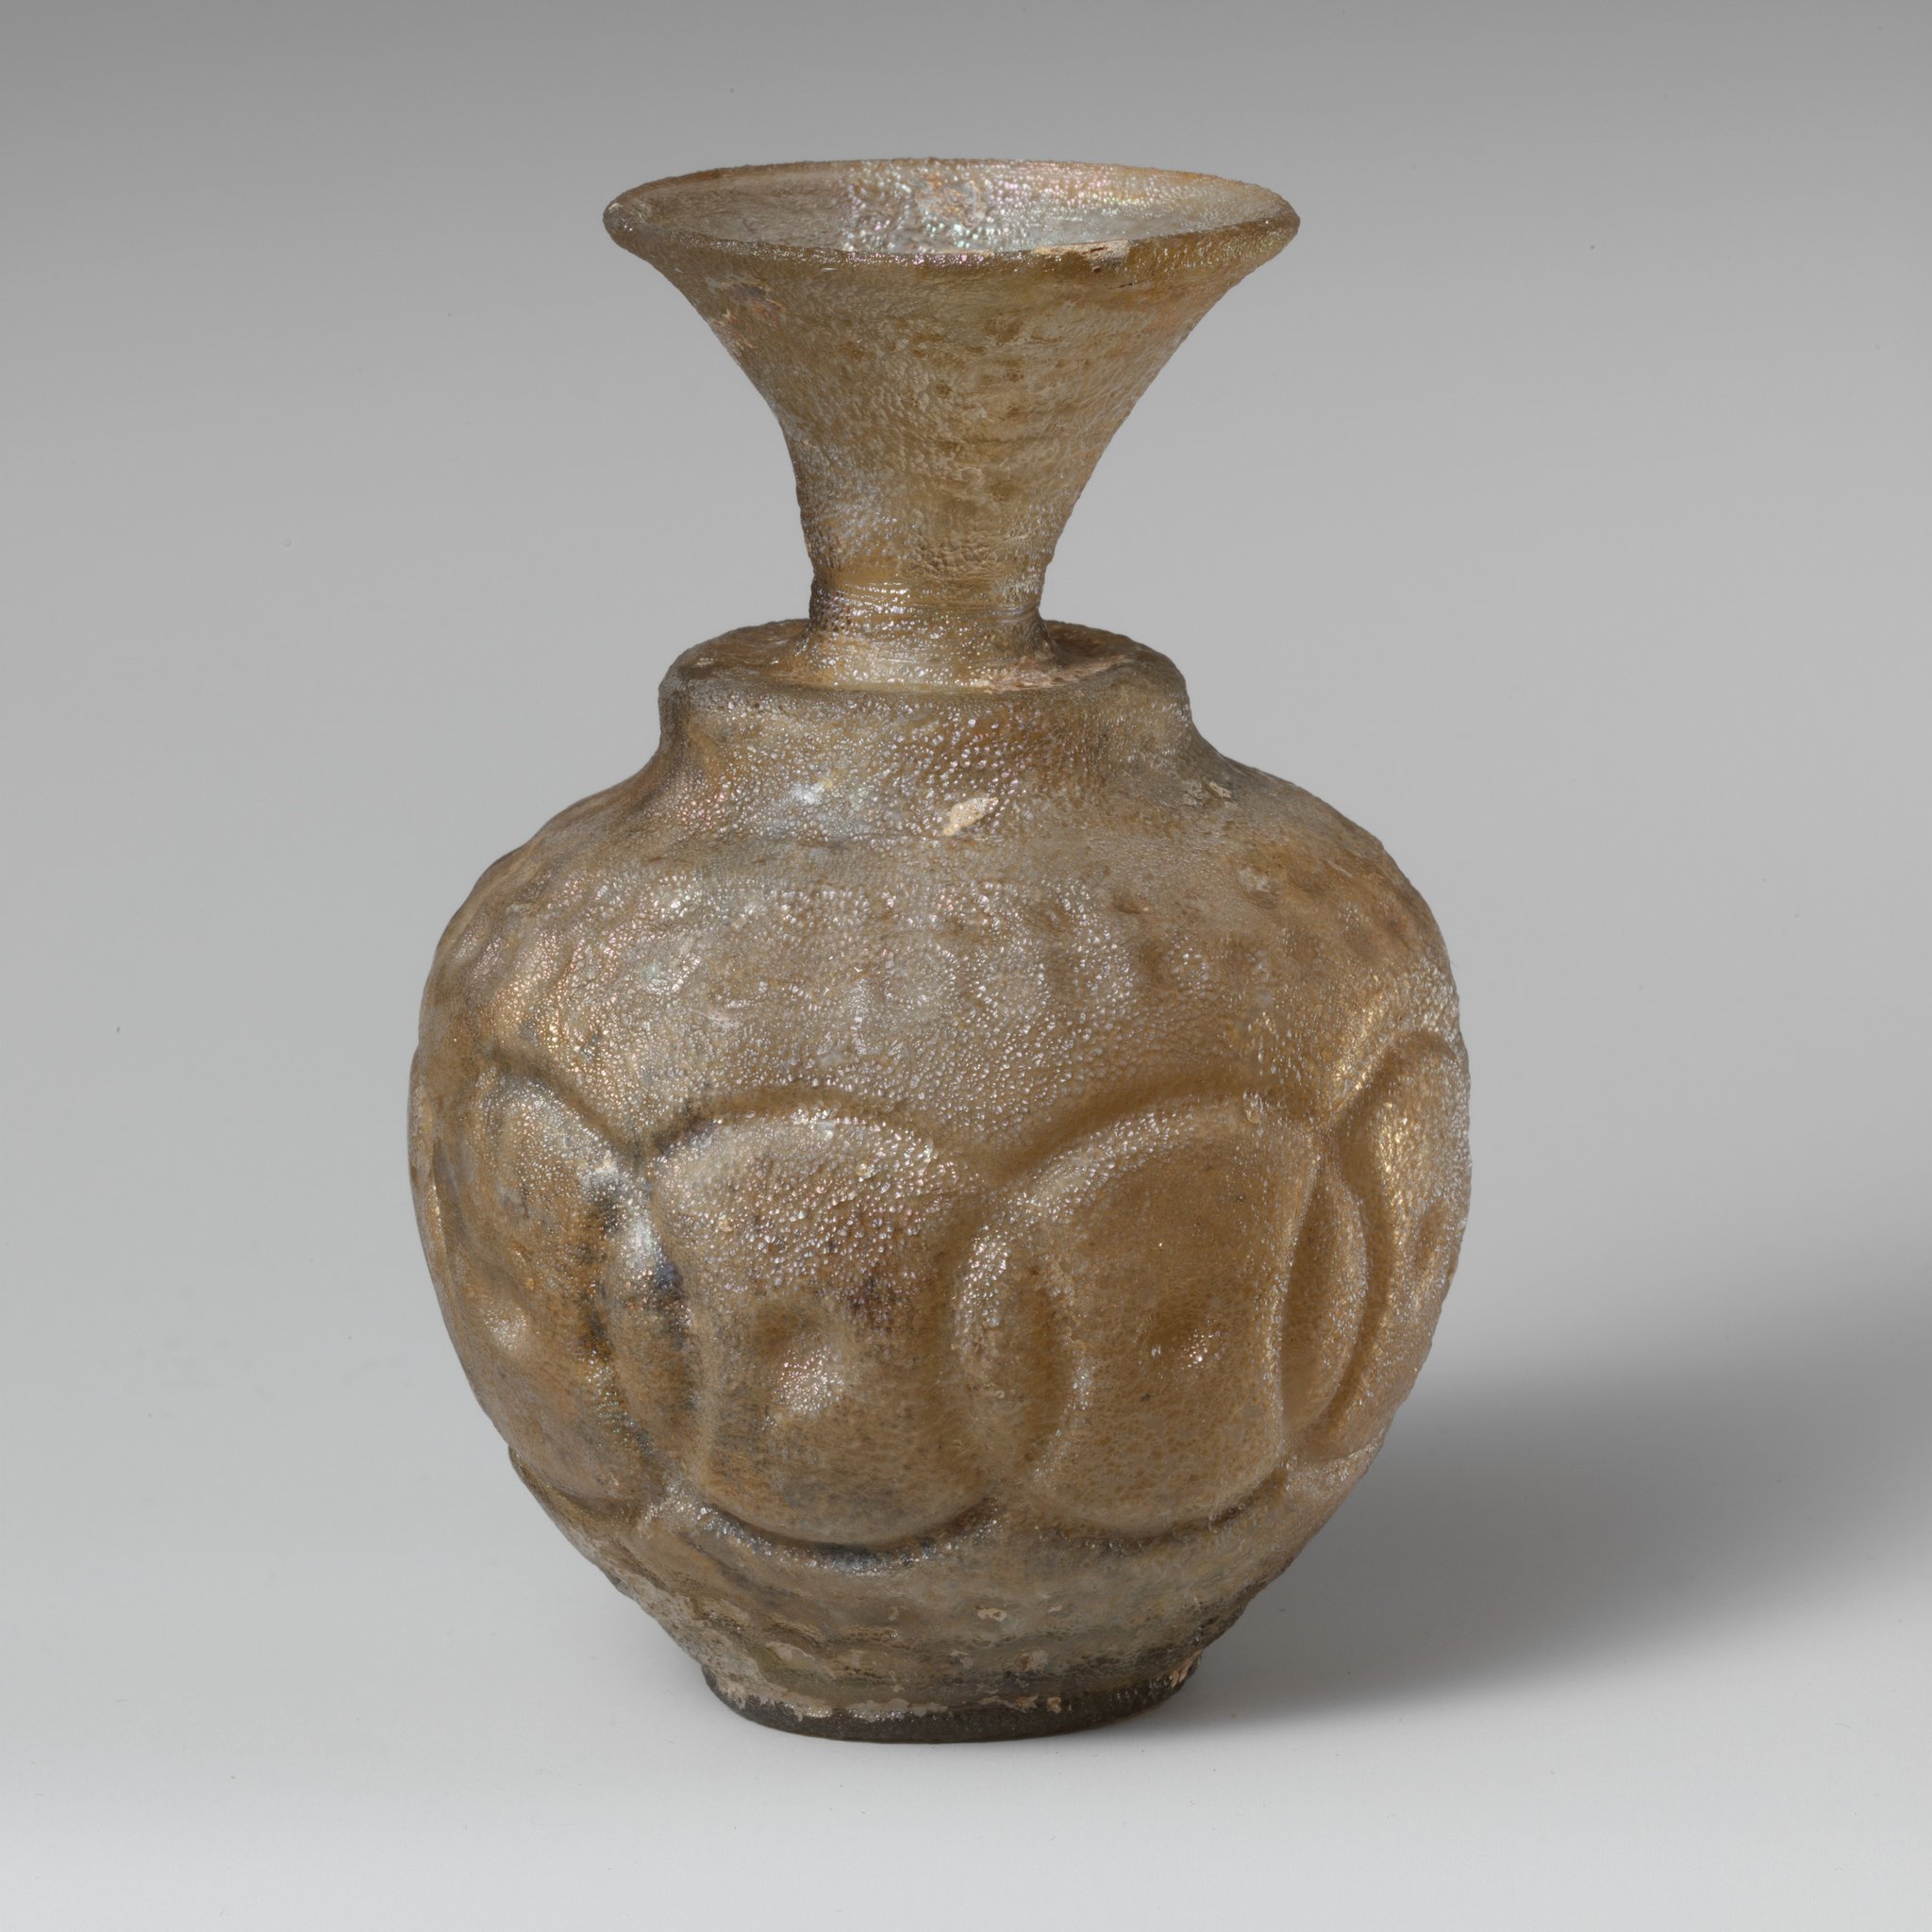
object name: flask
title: Glass flask decorated with intersecting circles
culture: roman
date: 101-300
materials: glass